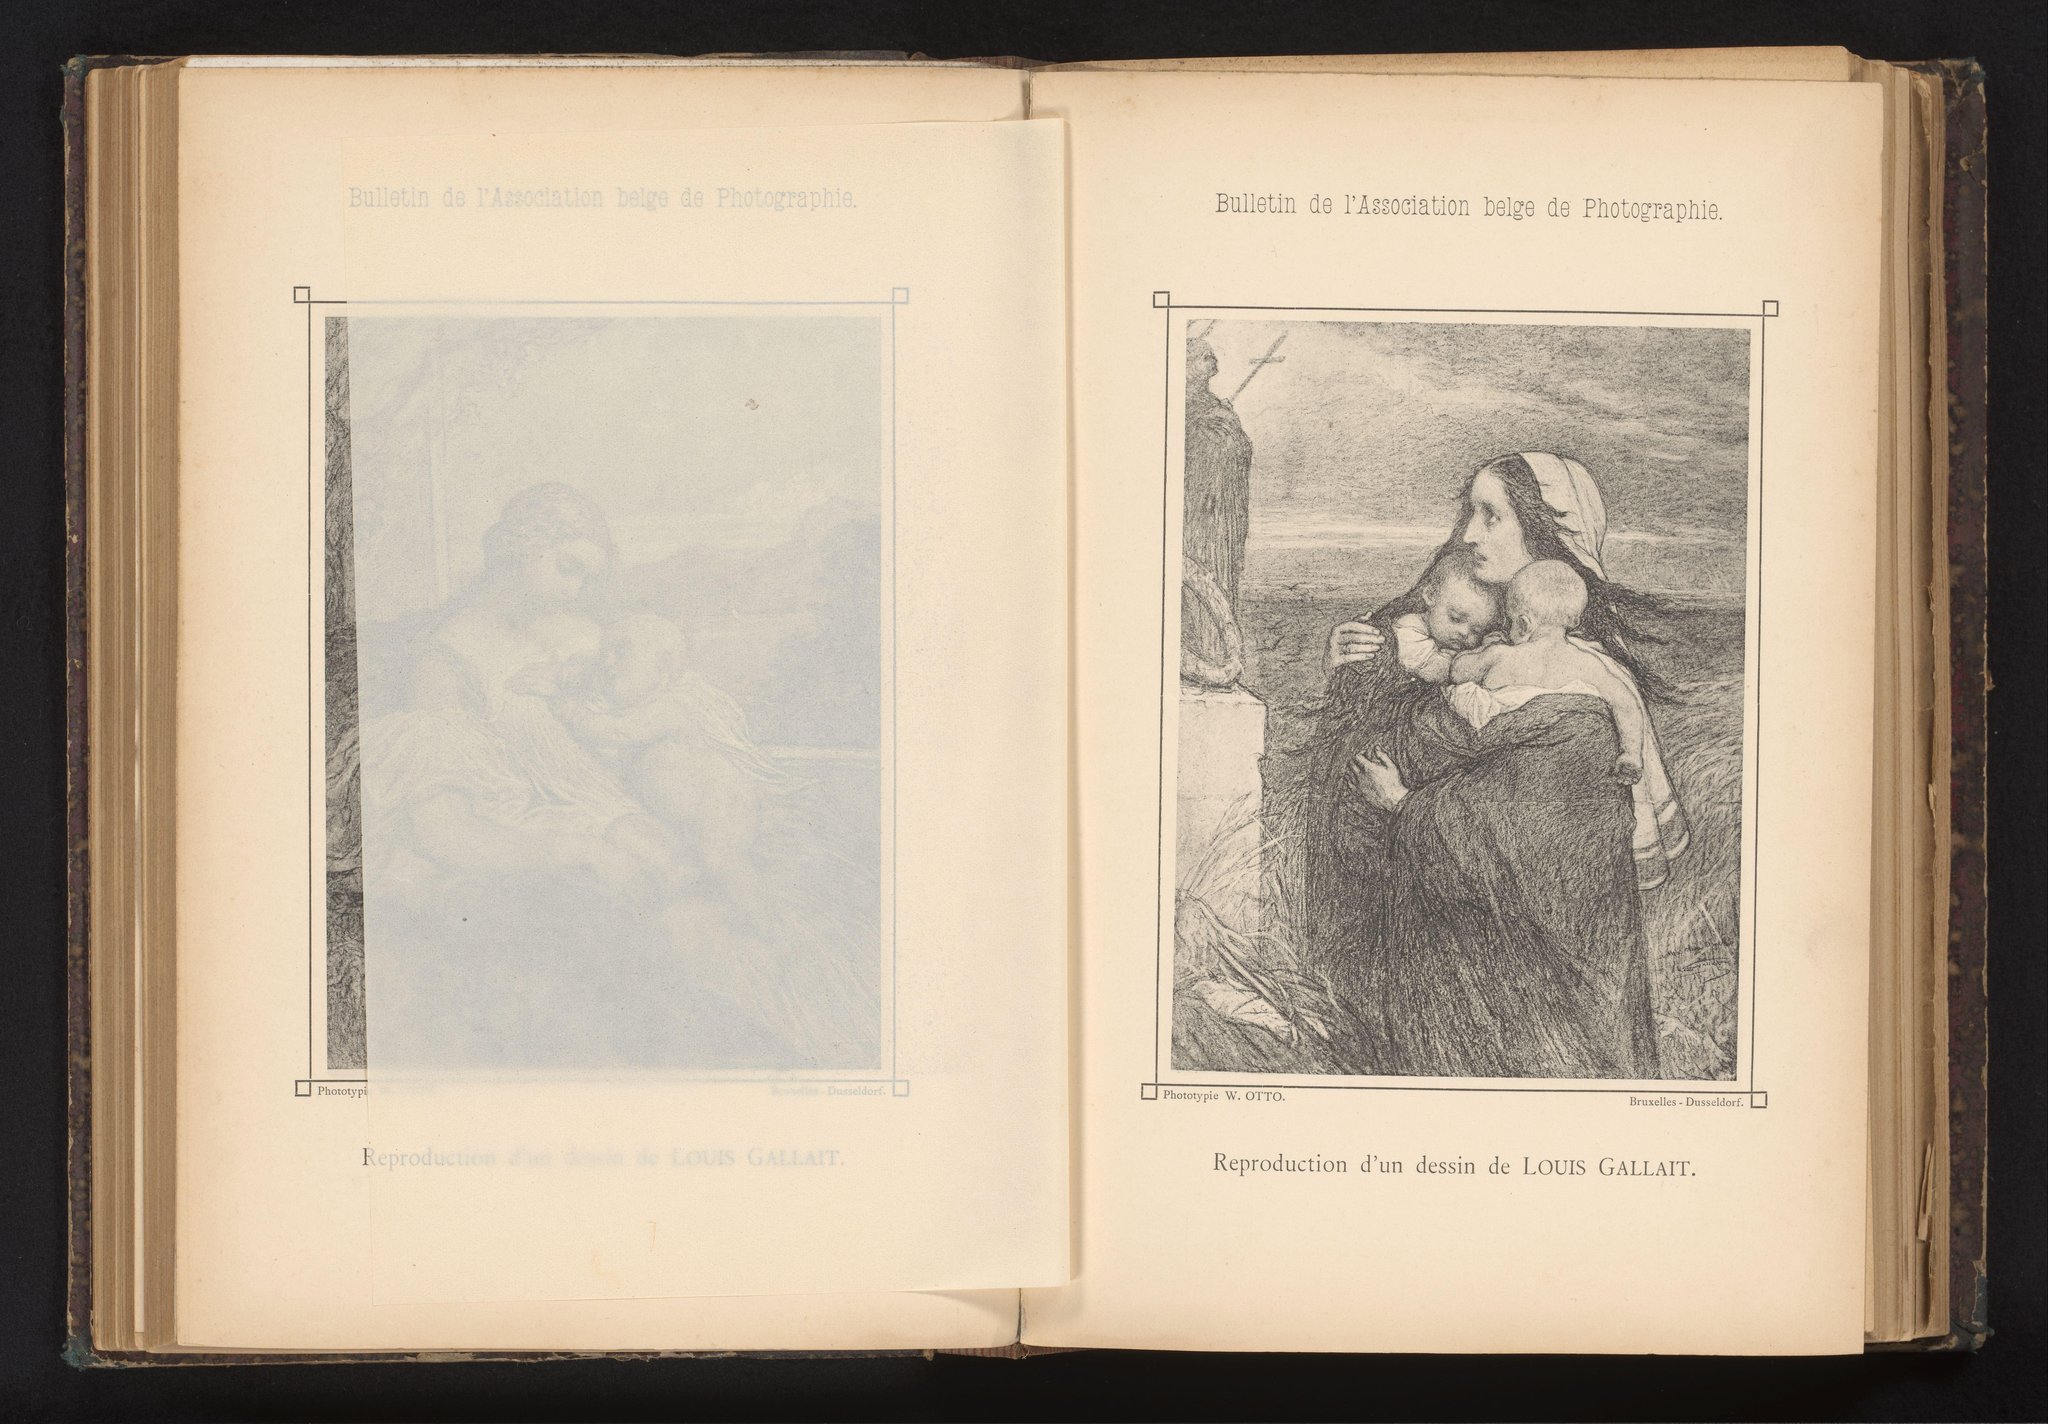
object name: reproduction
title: Reproduction d'un dessin de Louis Gallait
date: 1883-1888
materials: paper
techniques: photograph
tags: adult woman, infant, baby, painting, drawing and the graphic arts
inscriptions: inscription: ‘Bulletin de l'association belge de photographie’